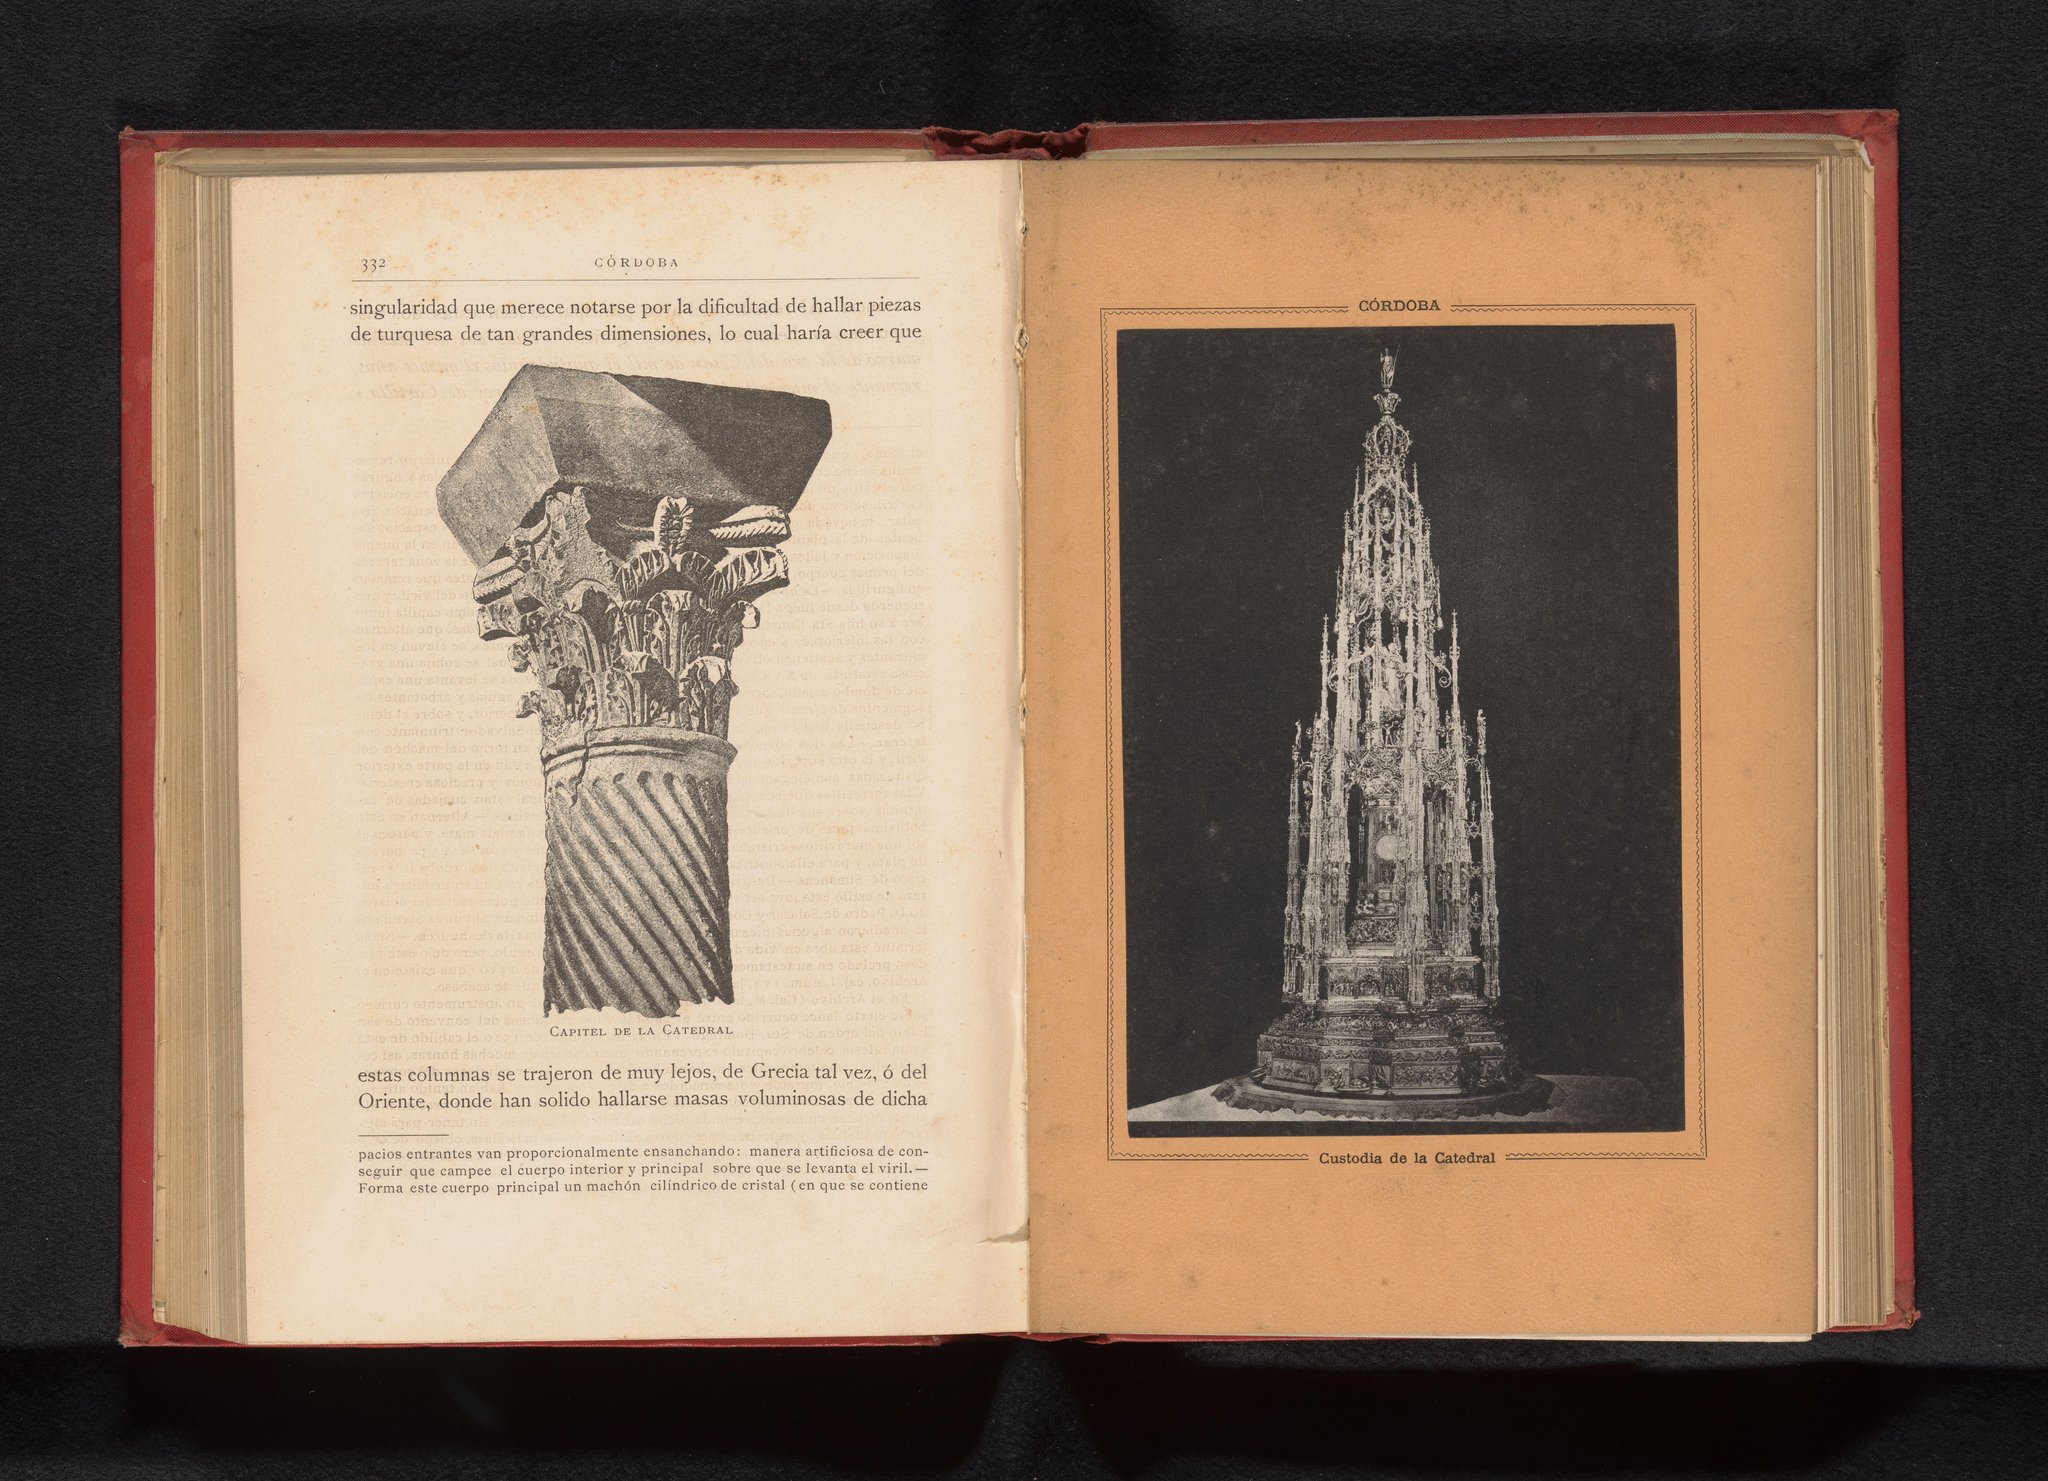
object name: page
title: Monstrans van de Mezquita te Córdoba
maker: Anonymous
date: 1874-1884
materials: paper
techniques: photograph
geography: mezquita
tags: ostensorium, monstrance